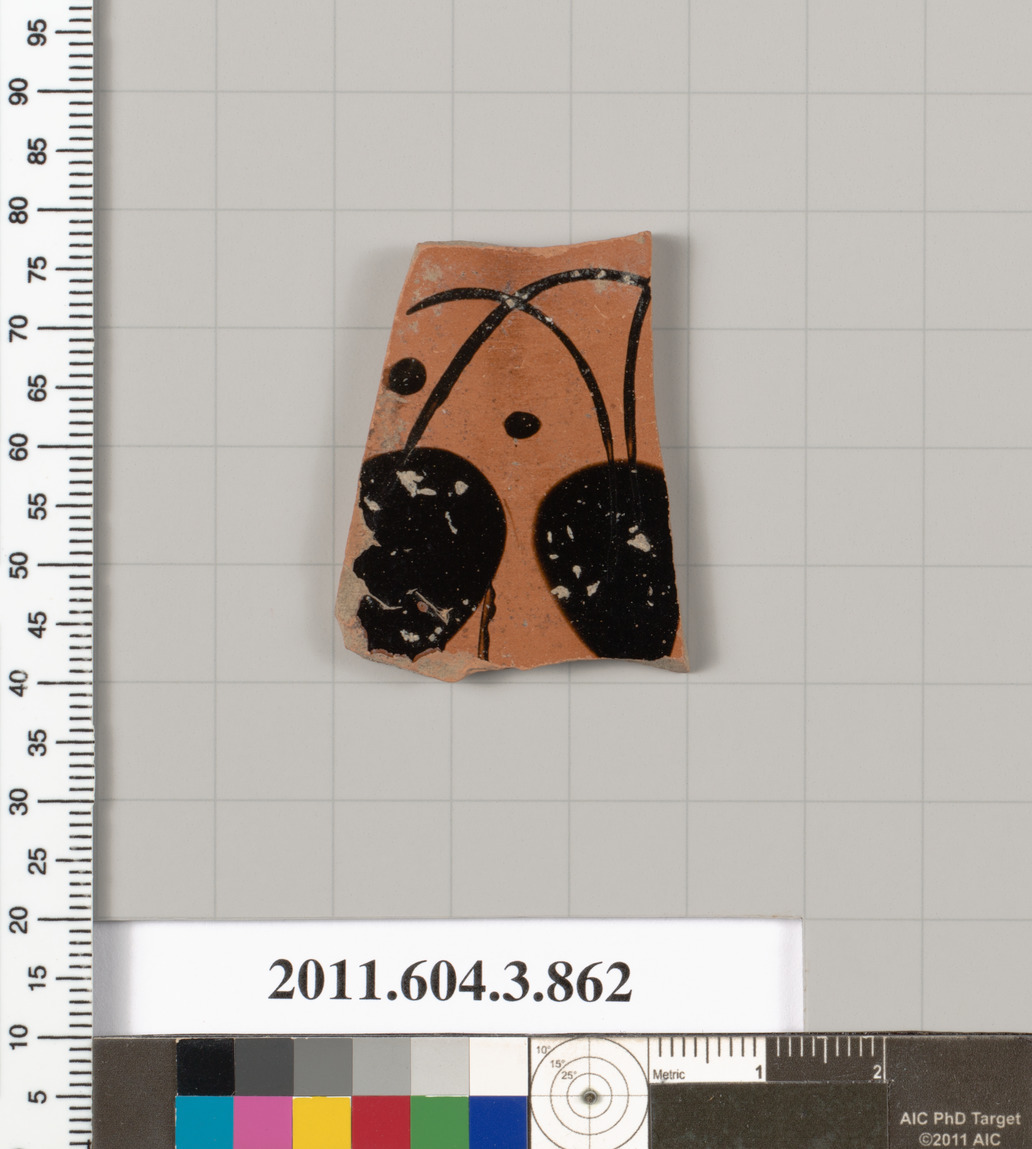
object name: lekythos fragment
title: Terracotta fragment of a lekythos (oil flask)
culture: greek, attic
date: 534-468 BCE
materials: terracotta